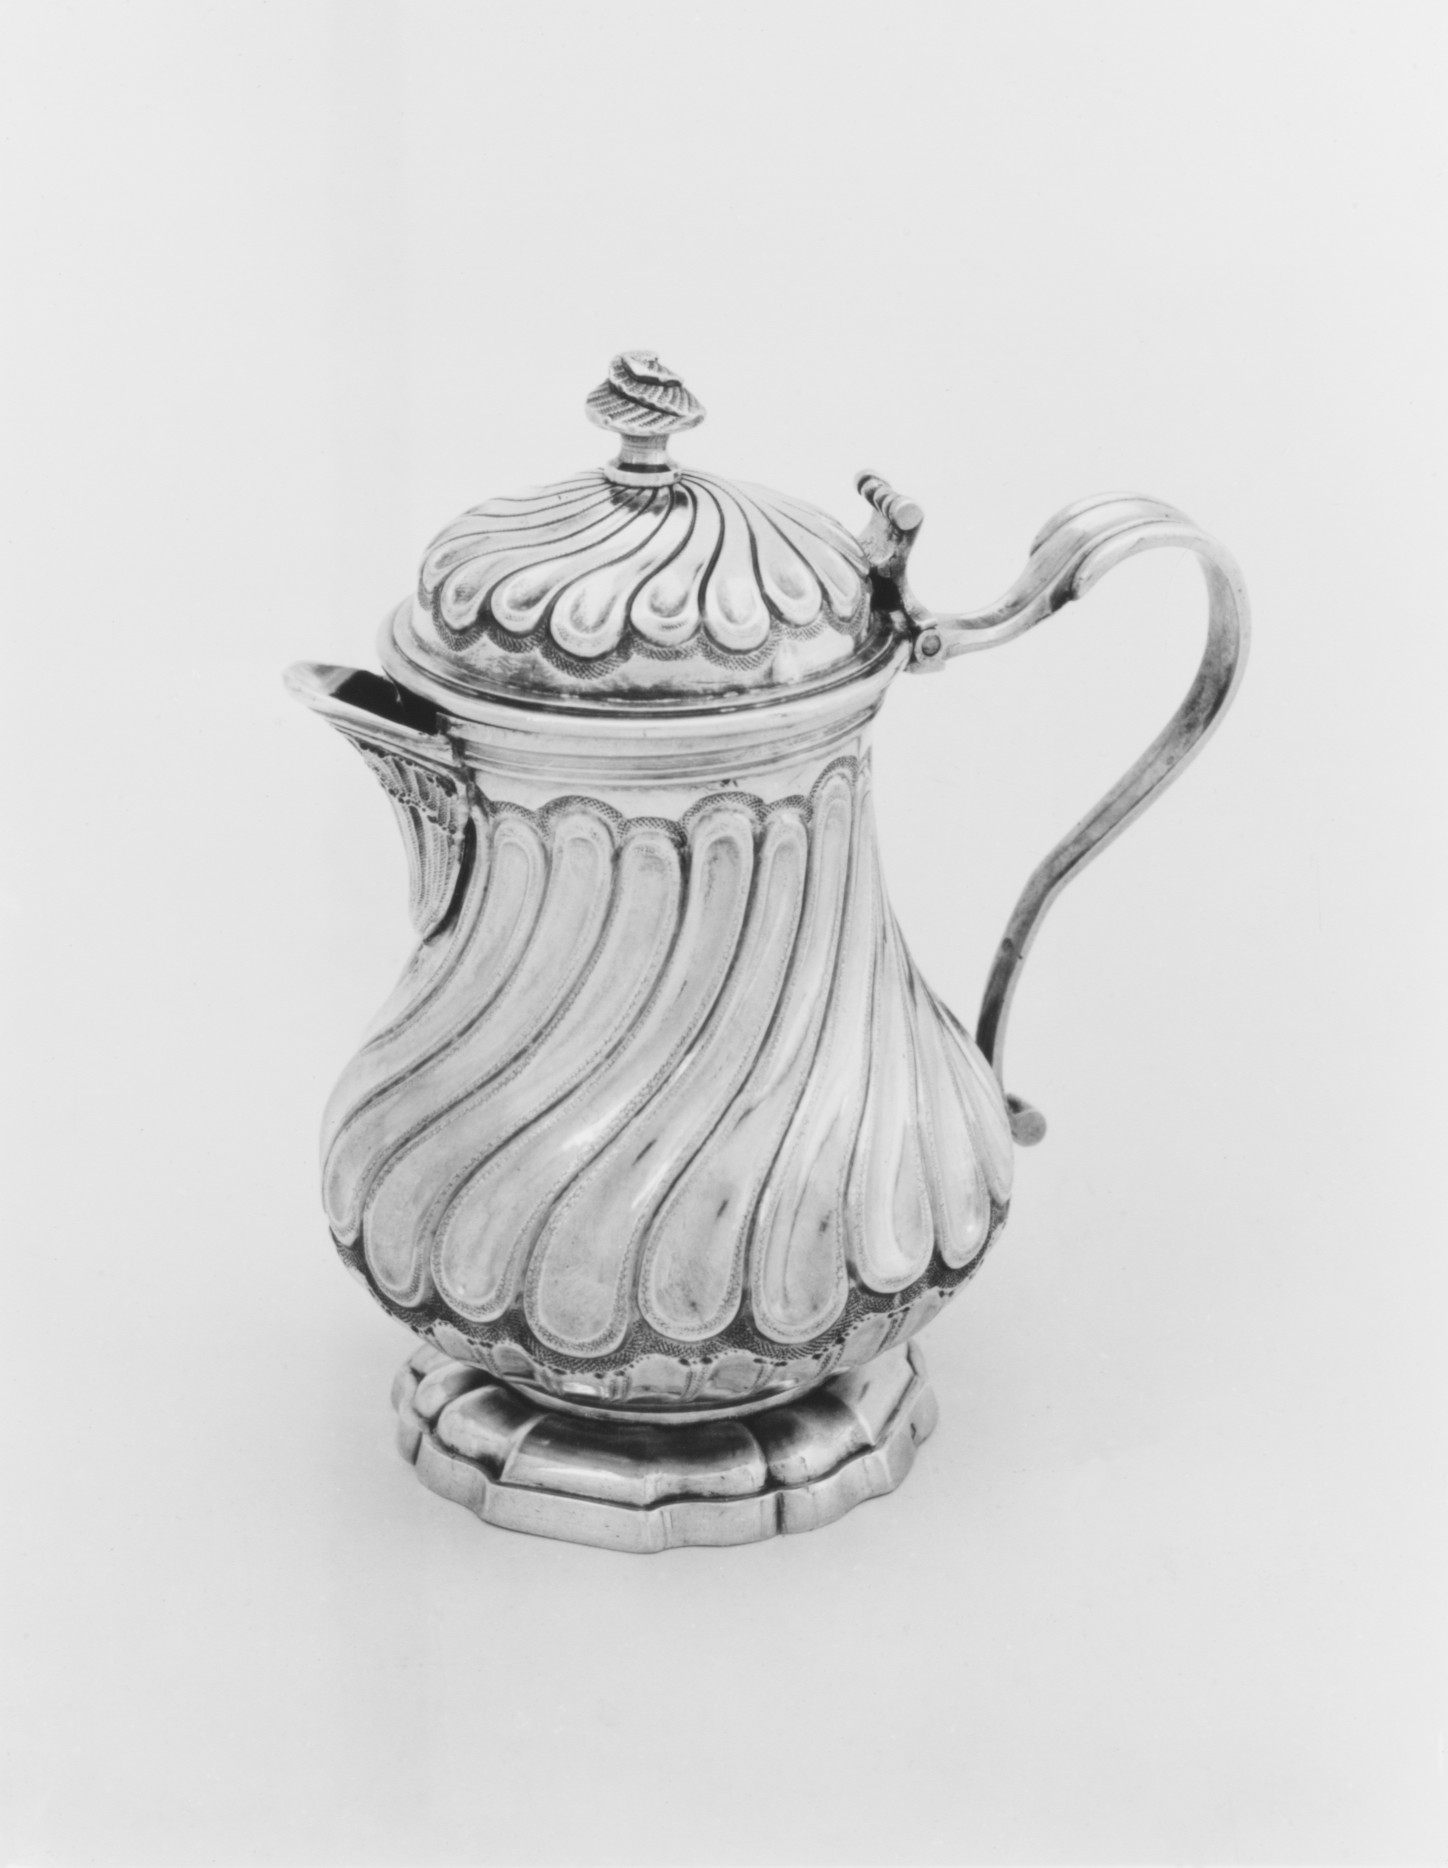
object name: mustard pot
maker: alexis micalef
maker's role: maker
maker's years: 1726-1818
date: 1768-1769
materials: silver